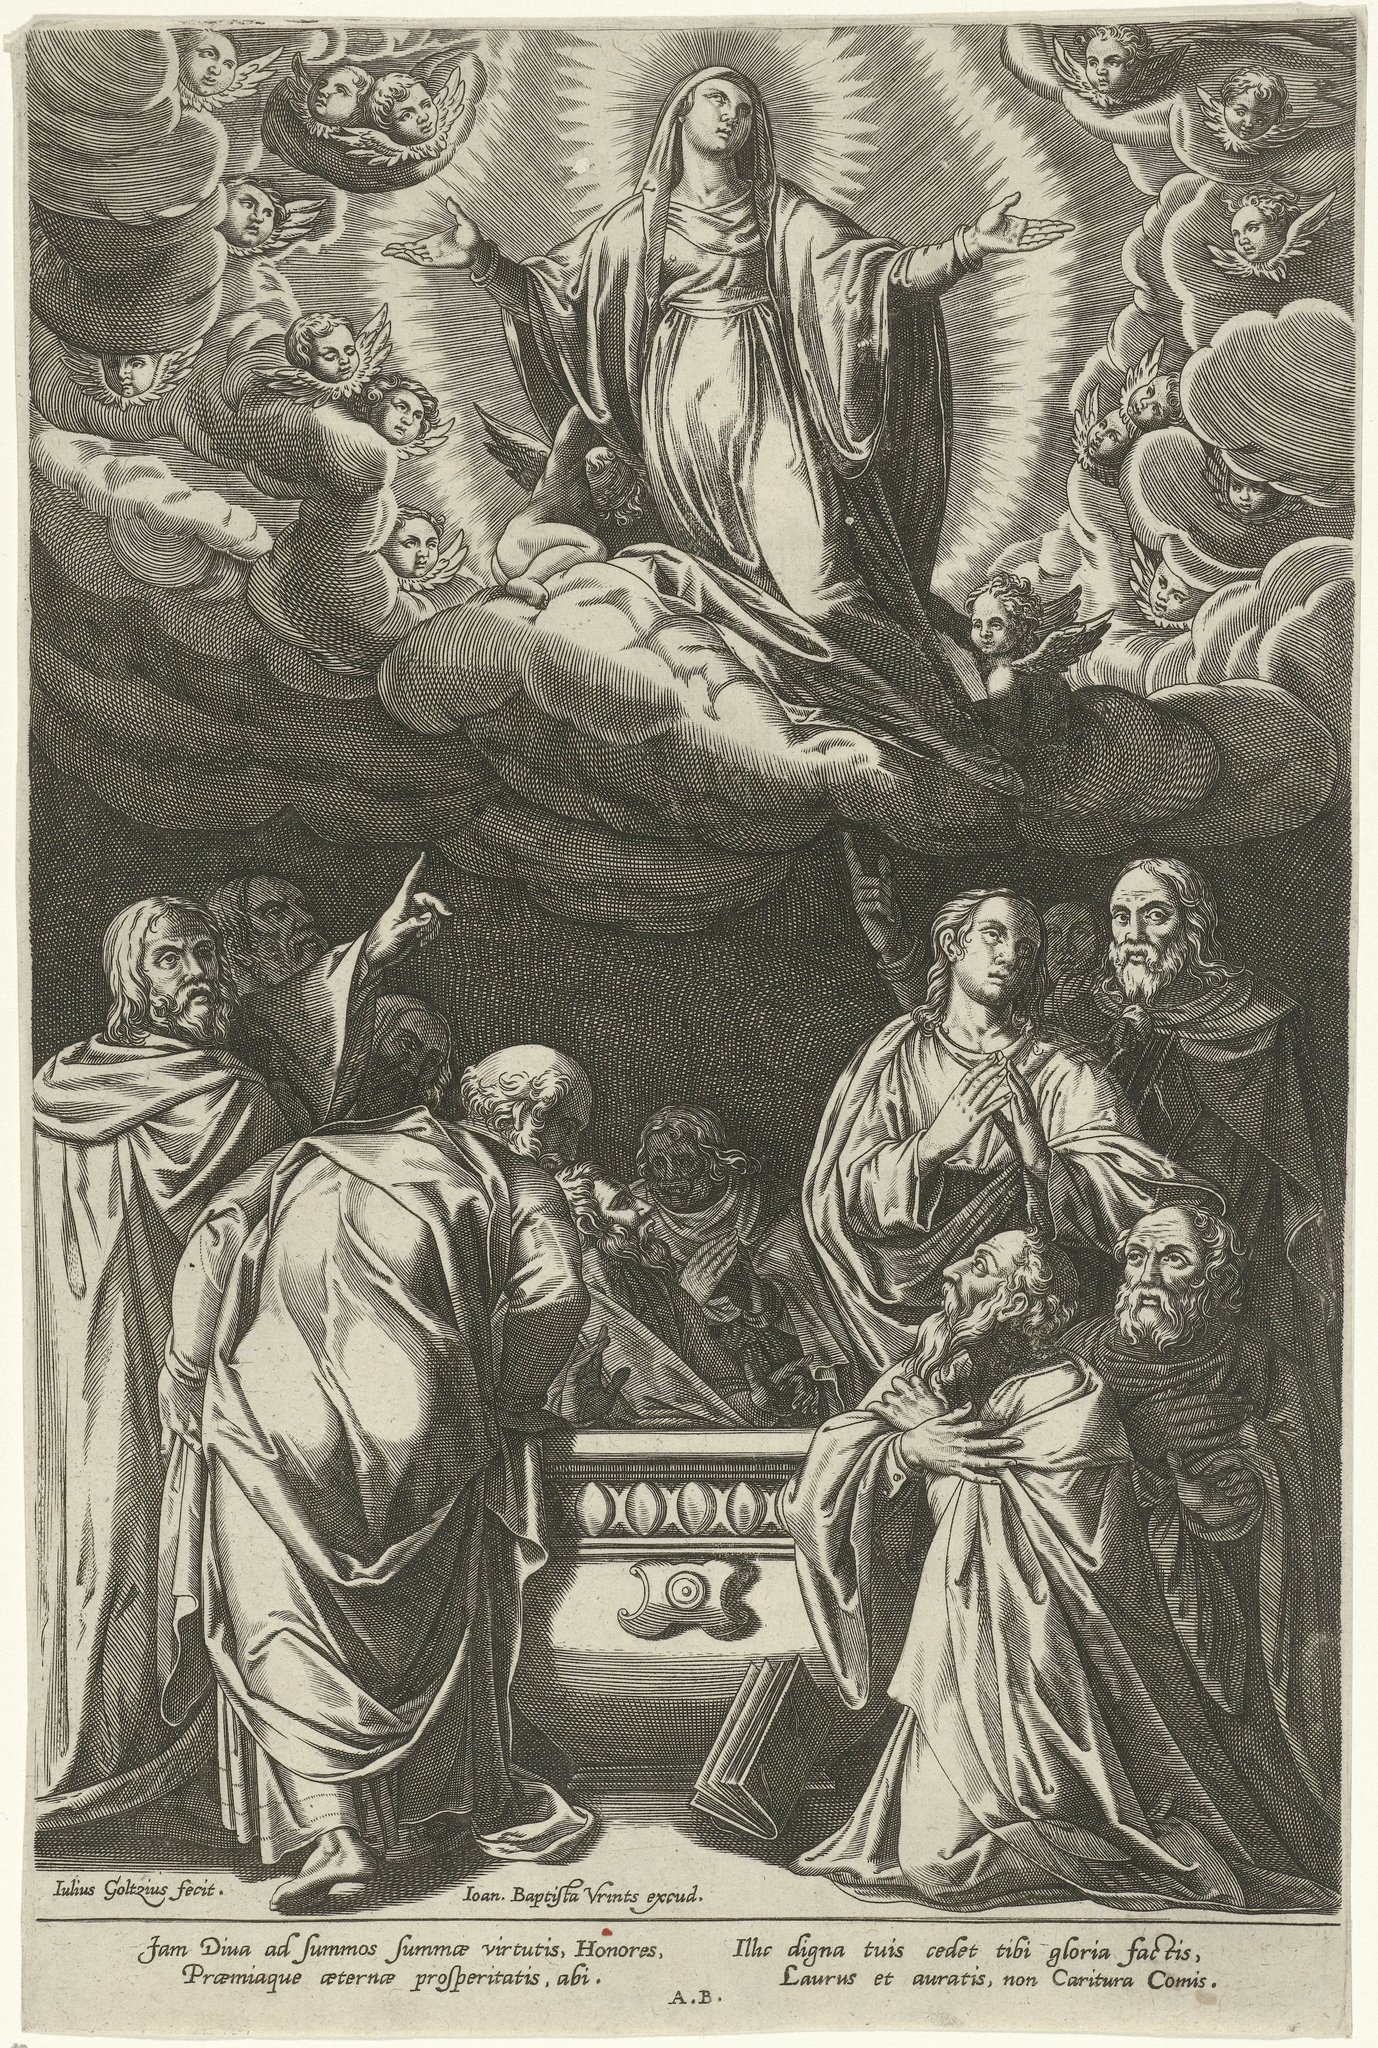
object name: print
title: Hemelvaart van Maria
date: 1575-1595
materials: paper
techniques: engraving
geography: antwerp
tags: the assumption of mary ('assumptio corporis'): she is borne into heaven by angels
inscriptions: collector's mark: Lugt 240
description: De apostelen zijn verzameld rondom de lege graftombe van Maria. In de lucht de knielende maagd Maria, haar armen uitgestrekt. Rondom haar het engelenkoor.